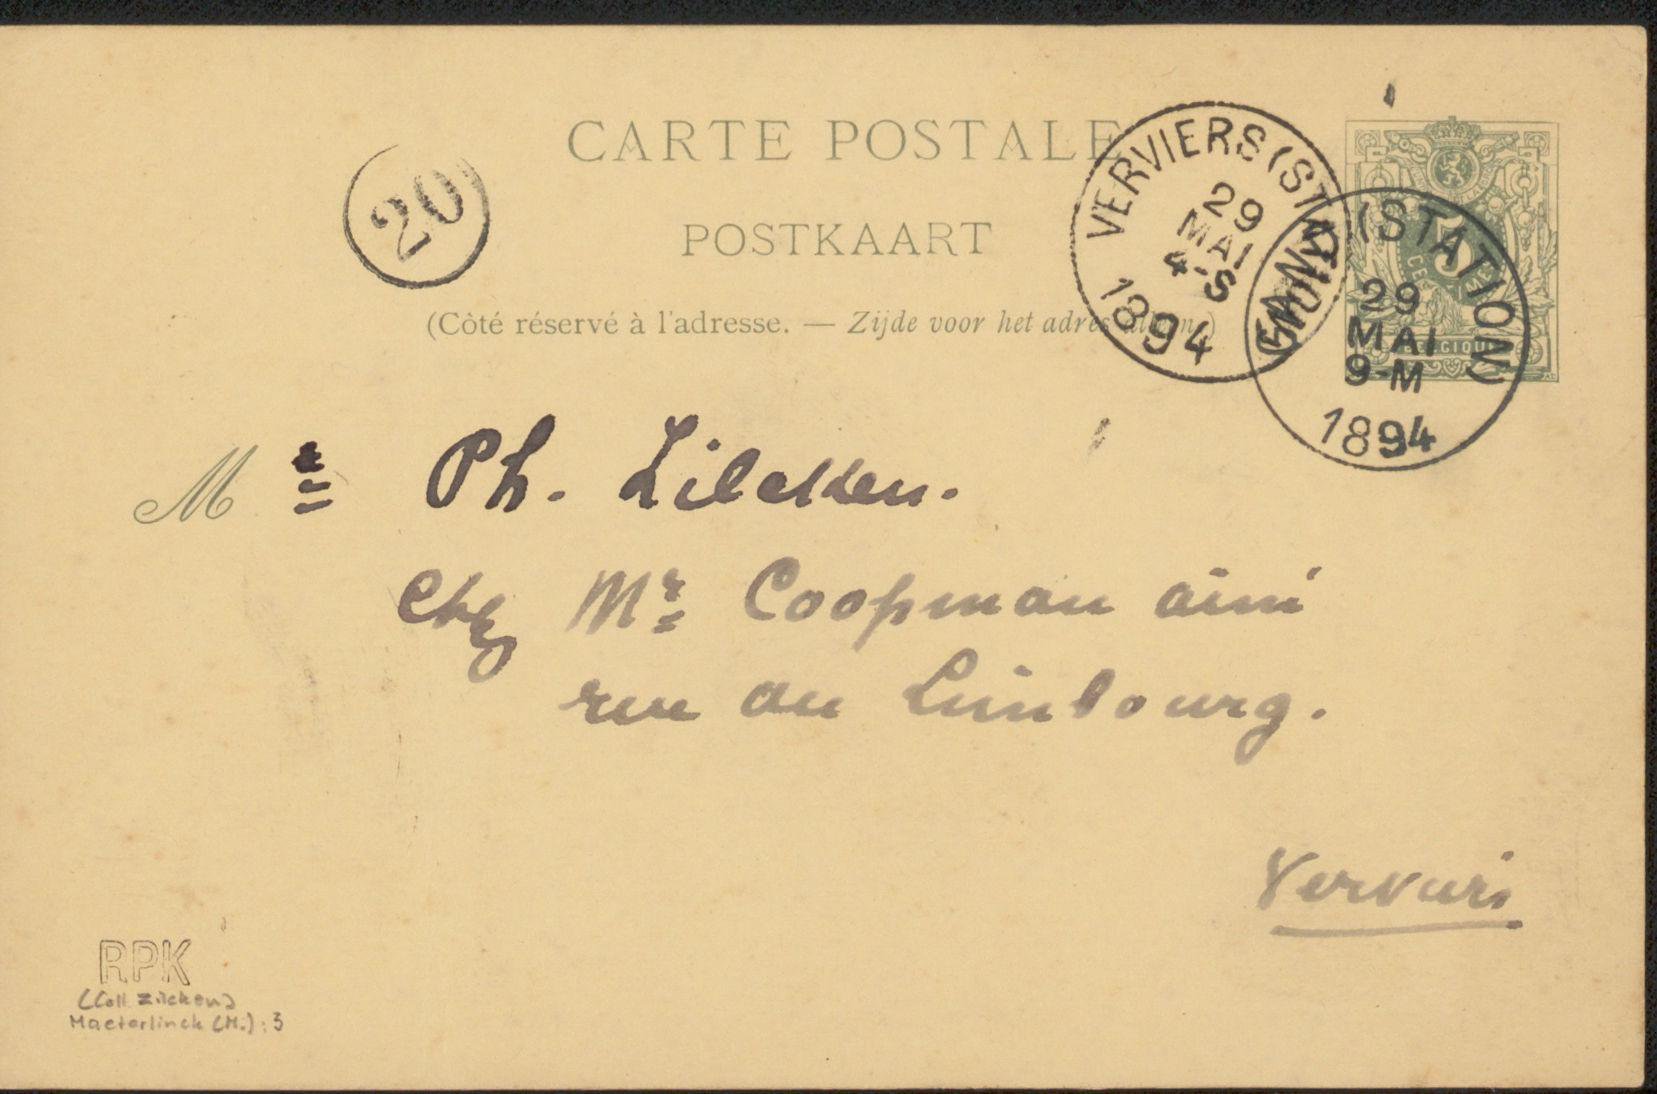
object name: postcard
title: Briefkaart aan Philip Zilcken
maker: maurice maeterlinck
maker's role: dichter, essayist, toneelschrijver, vertaler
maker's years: 1862-1949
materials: cardboard, ink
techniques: pen, writing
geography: ghent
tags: the hague, painter, draughtsman, philip zilcken, printed matter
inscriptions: collector's mark: ‘RPK’